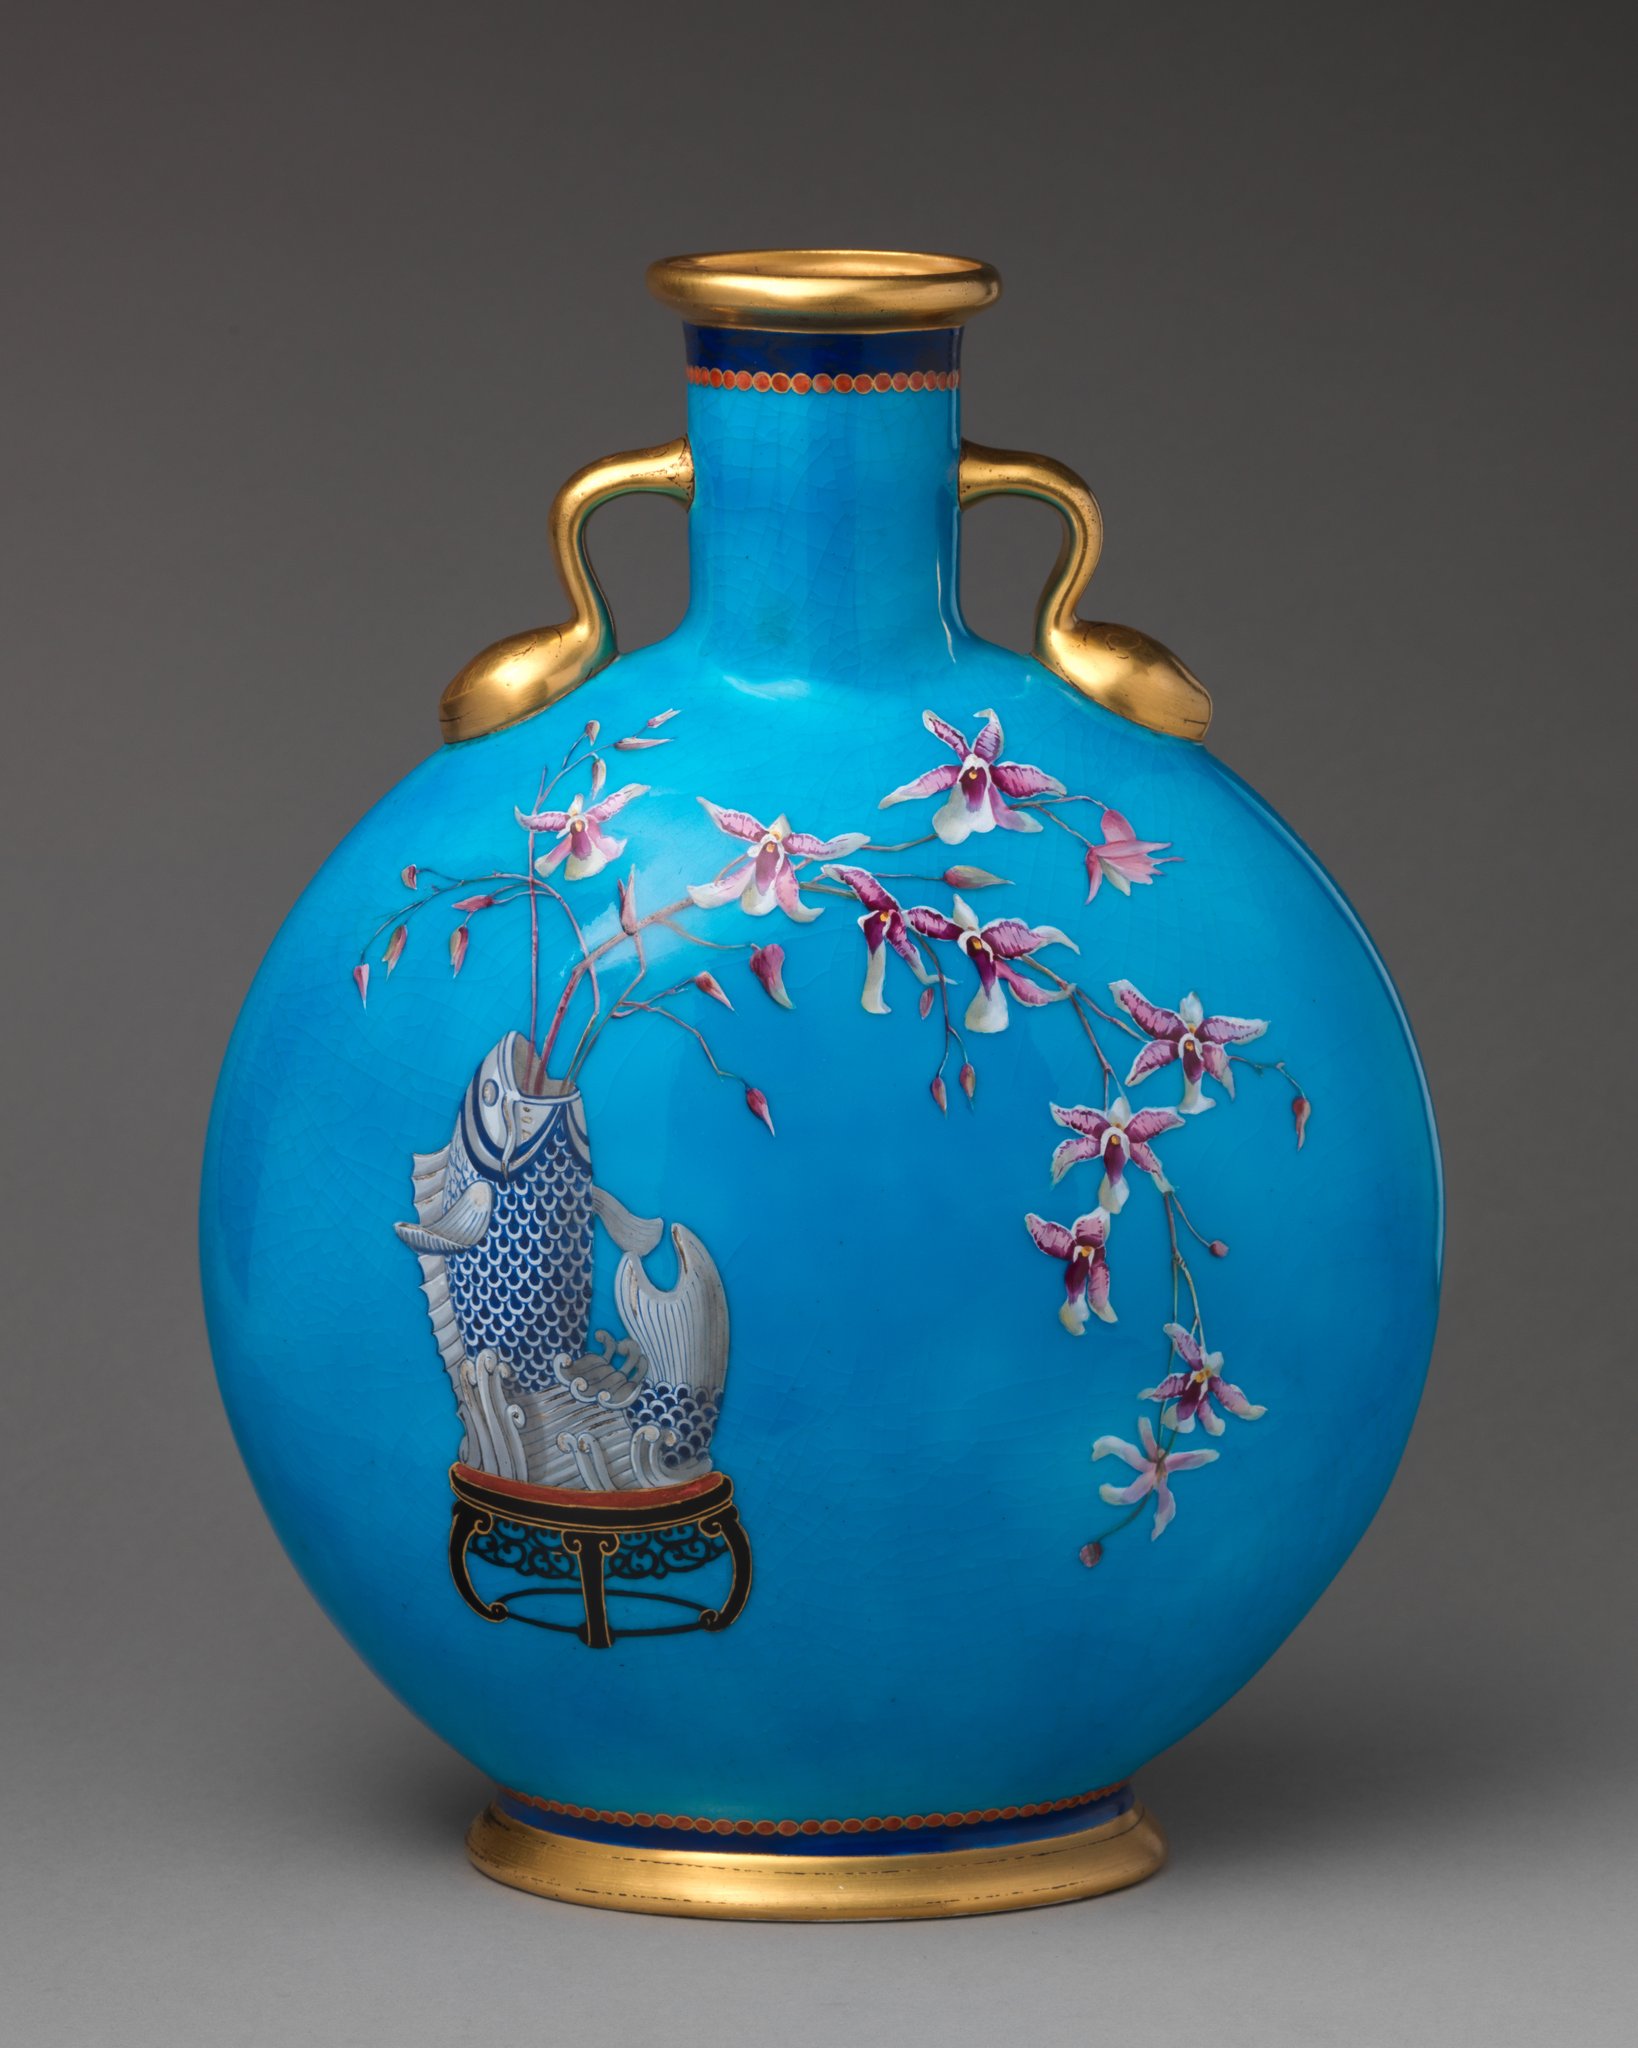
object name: moon flask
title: Moon flask with fish vase holding orchid spray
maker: minton(s)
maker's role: maker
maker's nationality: british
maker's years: 1793-2001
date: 1872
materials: bone china